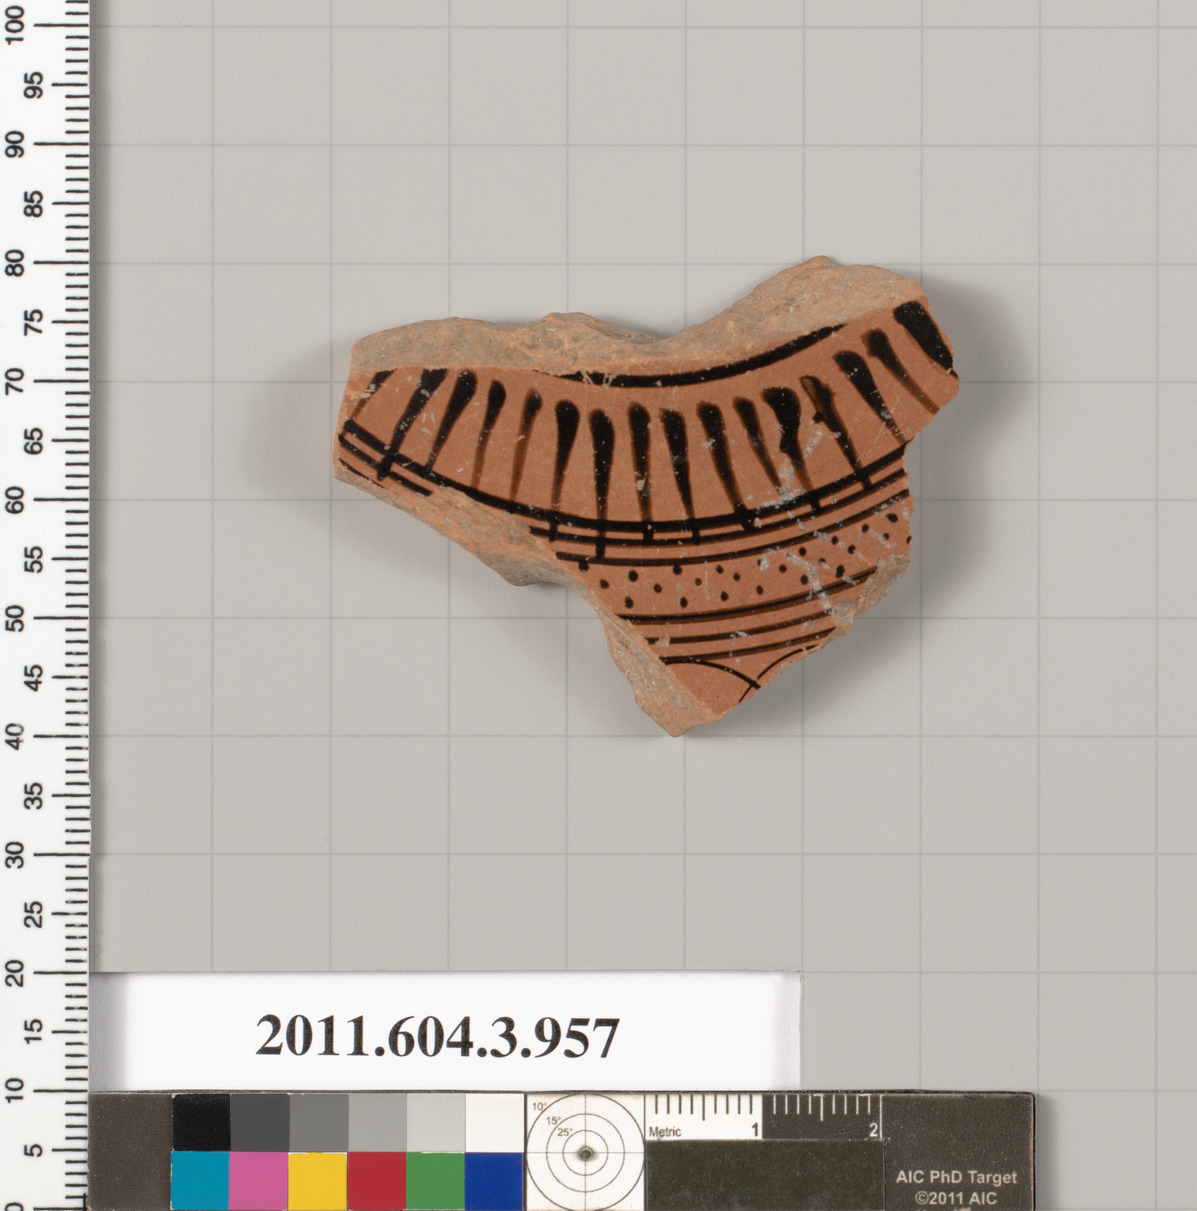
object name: lekanis lid fragment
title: Terracotta fragment of a lekanis lid (covered dish)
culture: greek, attic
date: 600-501 BCE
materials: terracotta